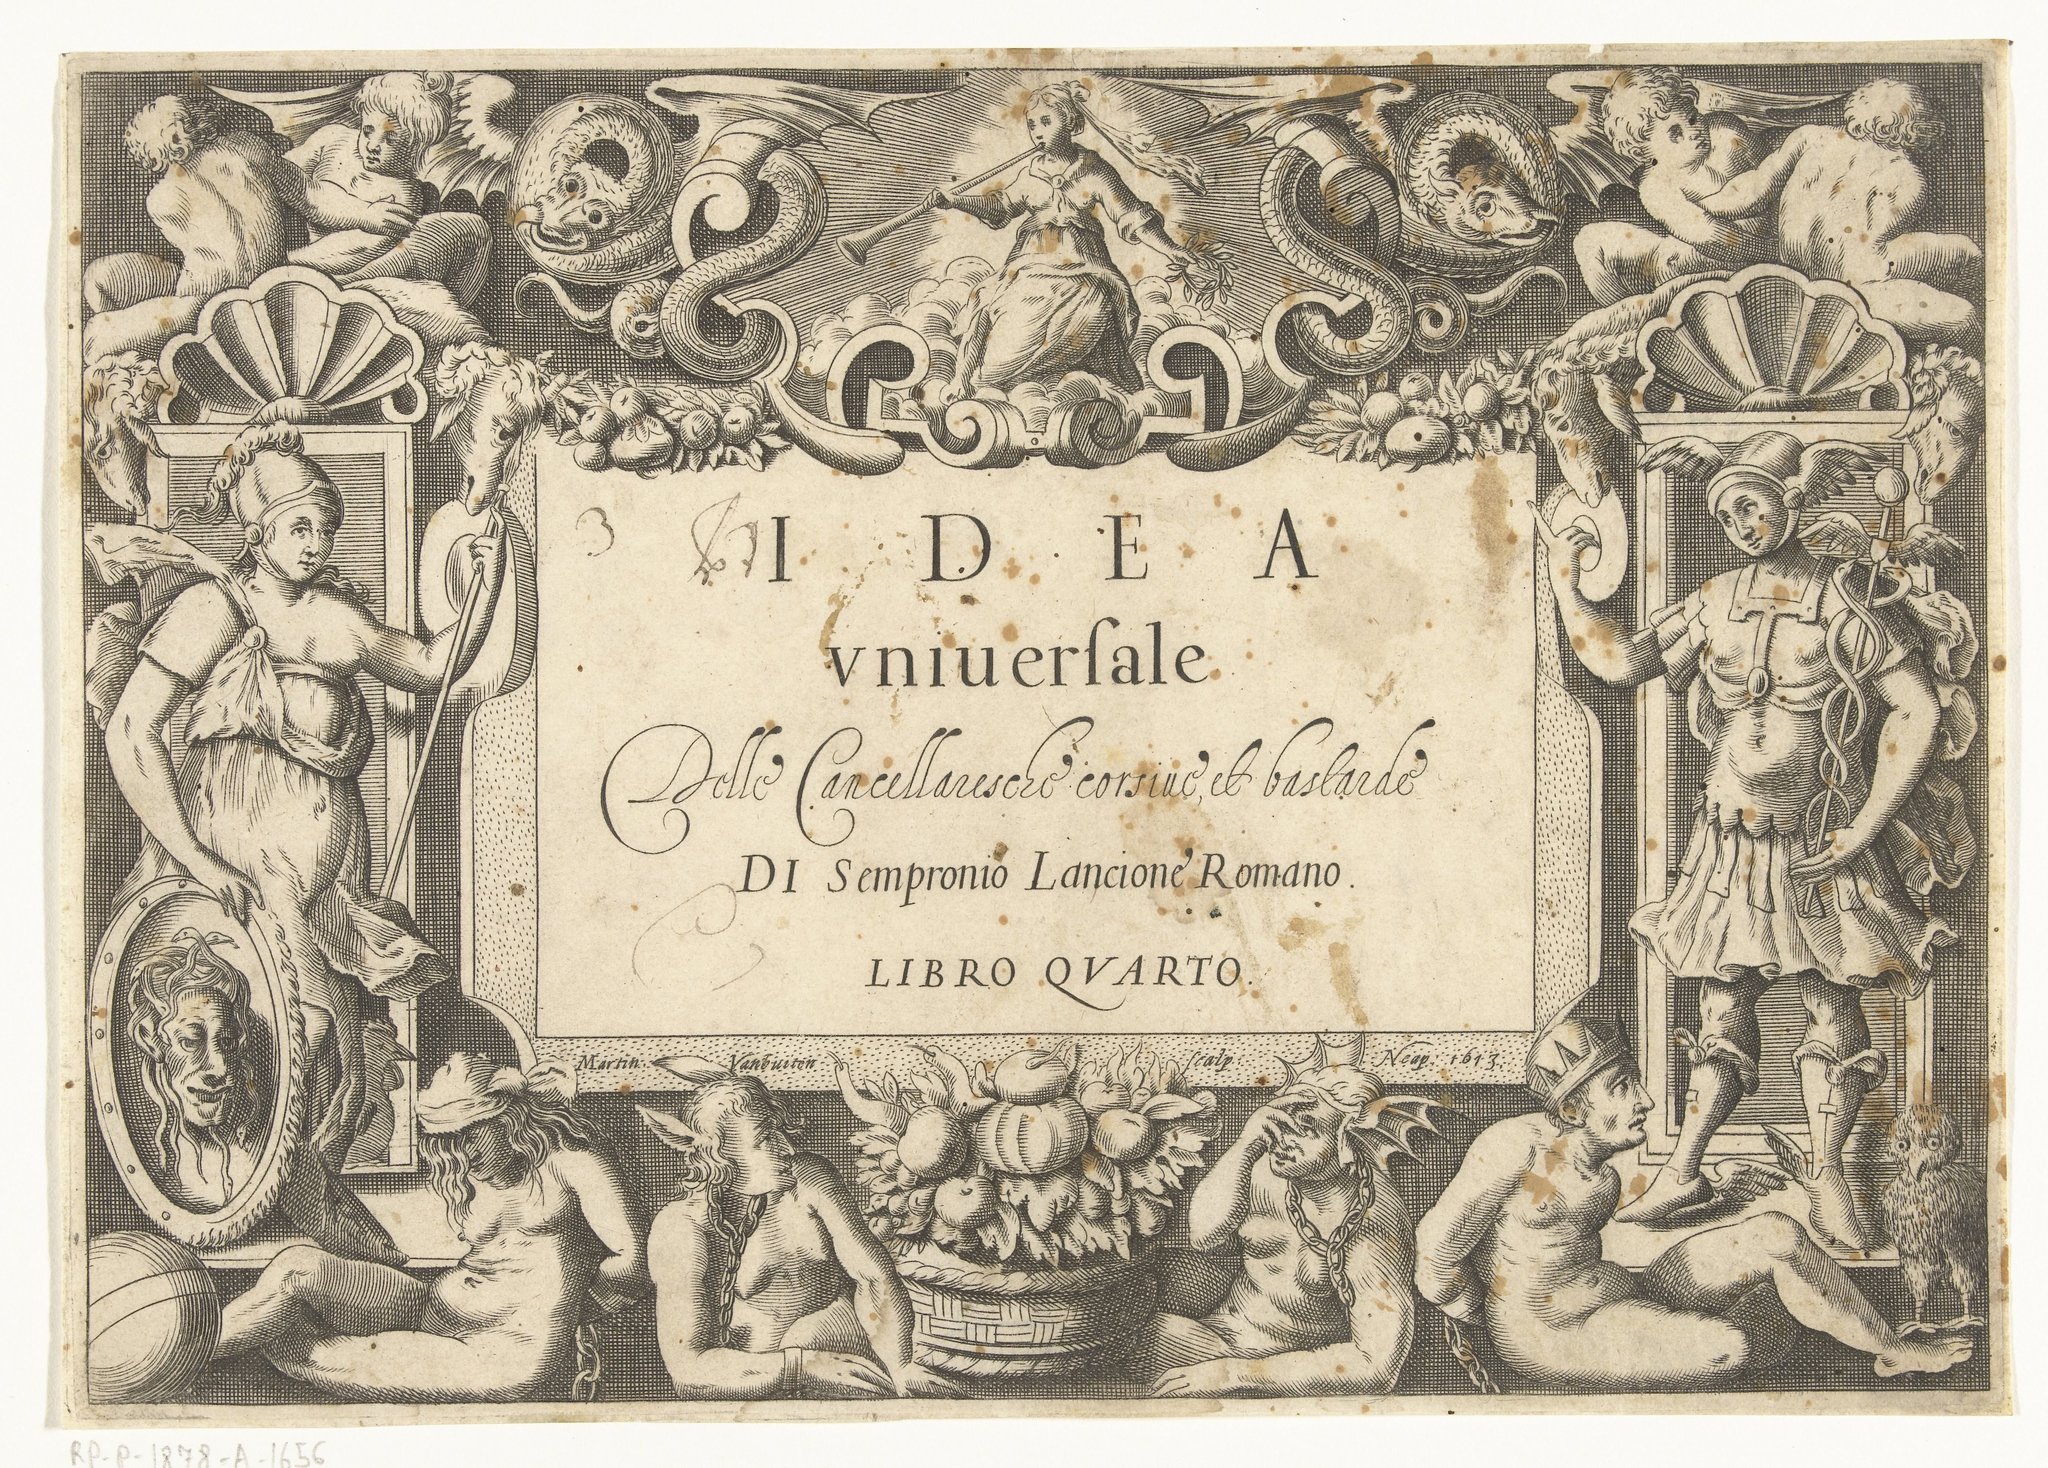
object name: titelblad, titelpagina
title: Titelpagina voor 'Idea universale della Cancellaresche corsive et bastarde'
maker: martin van buyten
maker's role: print maker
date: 1613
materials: paper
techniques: engraving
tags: dragon (large fabulous serpent, sometimes with wings and legs), (story of) minerva (pallas, athena), (story of) mercury (hermes), fame; 'fama', 'fama buona', 'fama chiara' (ripa), cupids: 'amores', 'amoretti', 'putti'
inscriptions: collector's mark: Lugt 2228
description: Titel in een cartouche. Rondom de cartouche verschillende mythologische figuren. Links van het midden Minerva. Rechts van het midden Mercurius. Onderaan gevangen figuren. Bovenaan putti en vliegende slangen. In een cartouche boven de titel speelt Fama een trompet en houdt ze een lauwerkrans vast.